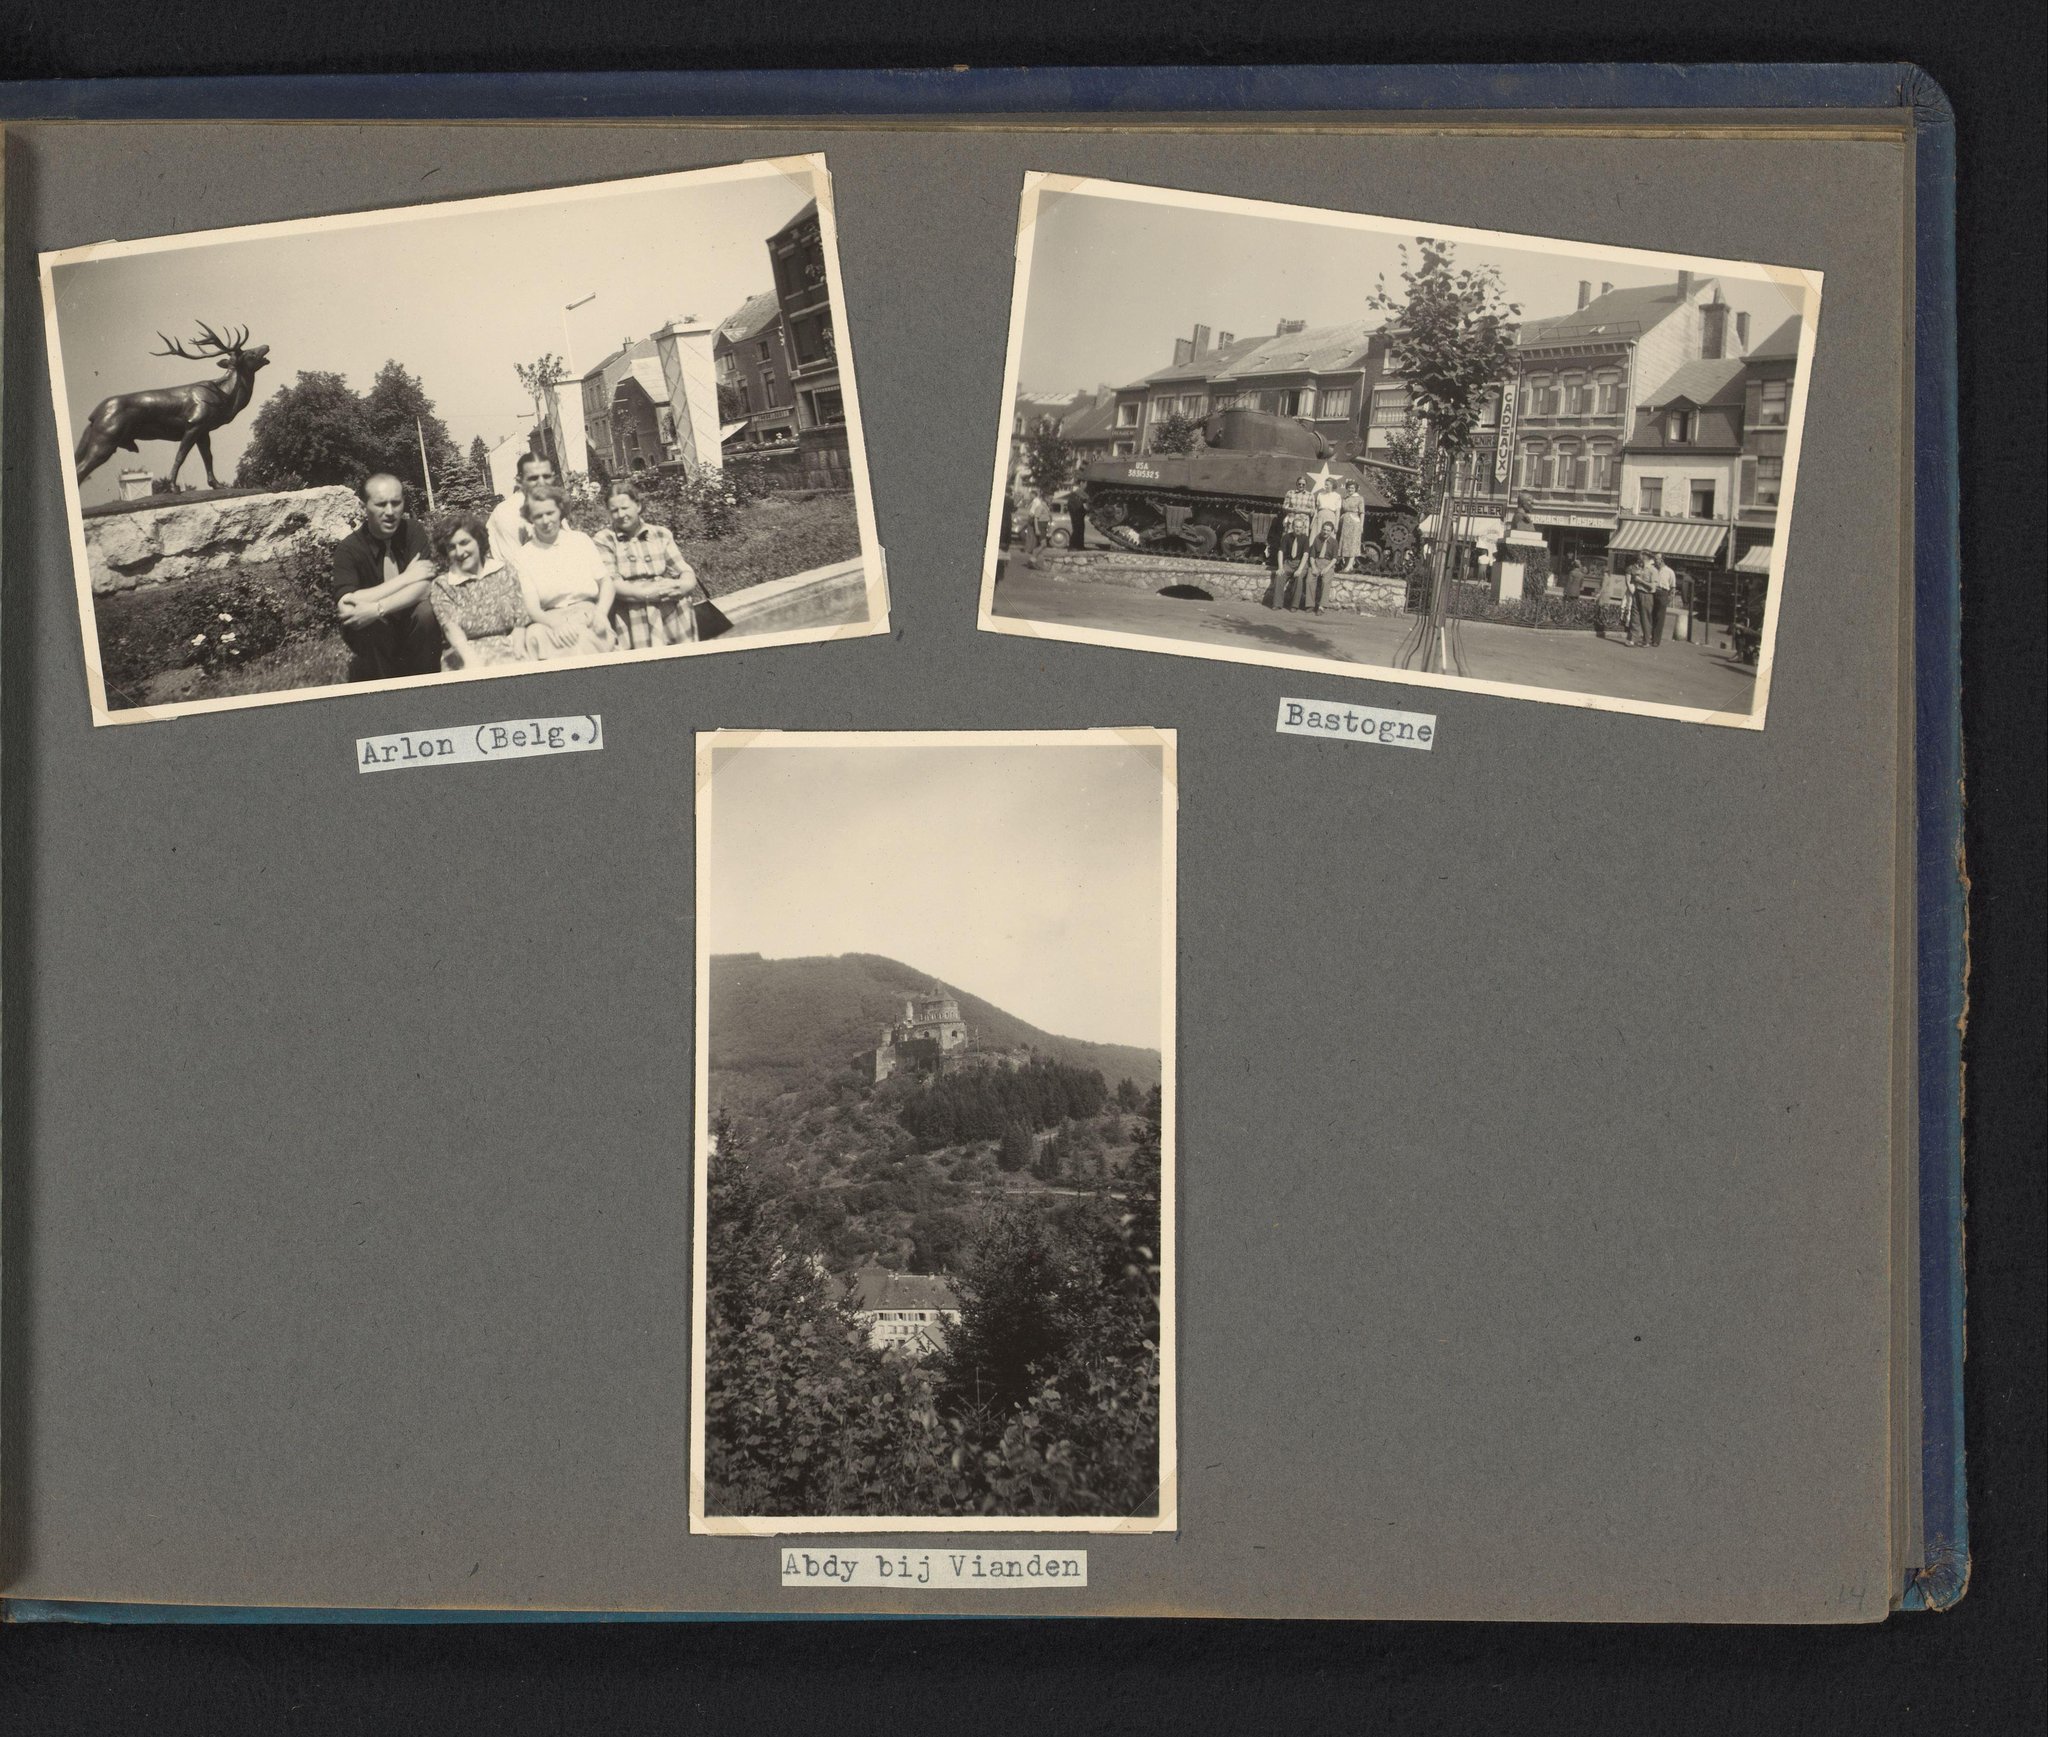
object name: photograph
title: Bezienswaardigheden in Luxemburg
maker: Anonymous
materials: paper, photographic support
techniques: gelatin silver print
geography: luxembourg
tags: the family travelling, on holiday, outing, pleasure trip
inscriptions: inscription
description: Albumblad met drie foto's genomen tijdens een autovakantie. Bezienswaardigheden in Luxemburg. Onder de foto's uitgeknipte papiertjes met getypte opschriften. Onderdeel van het derde fotoalbum met foto's van familievakanties in Nederland, België en Luxemburg in 1952-1953.